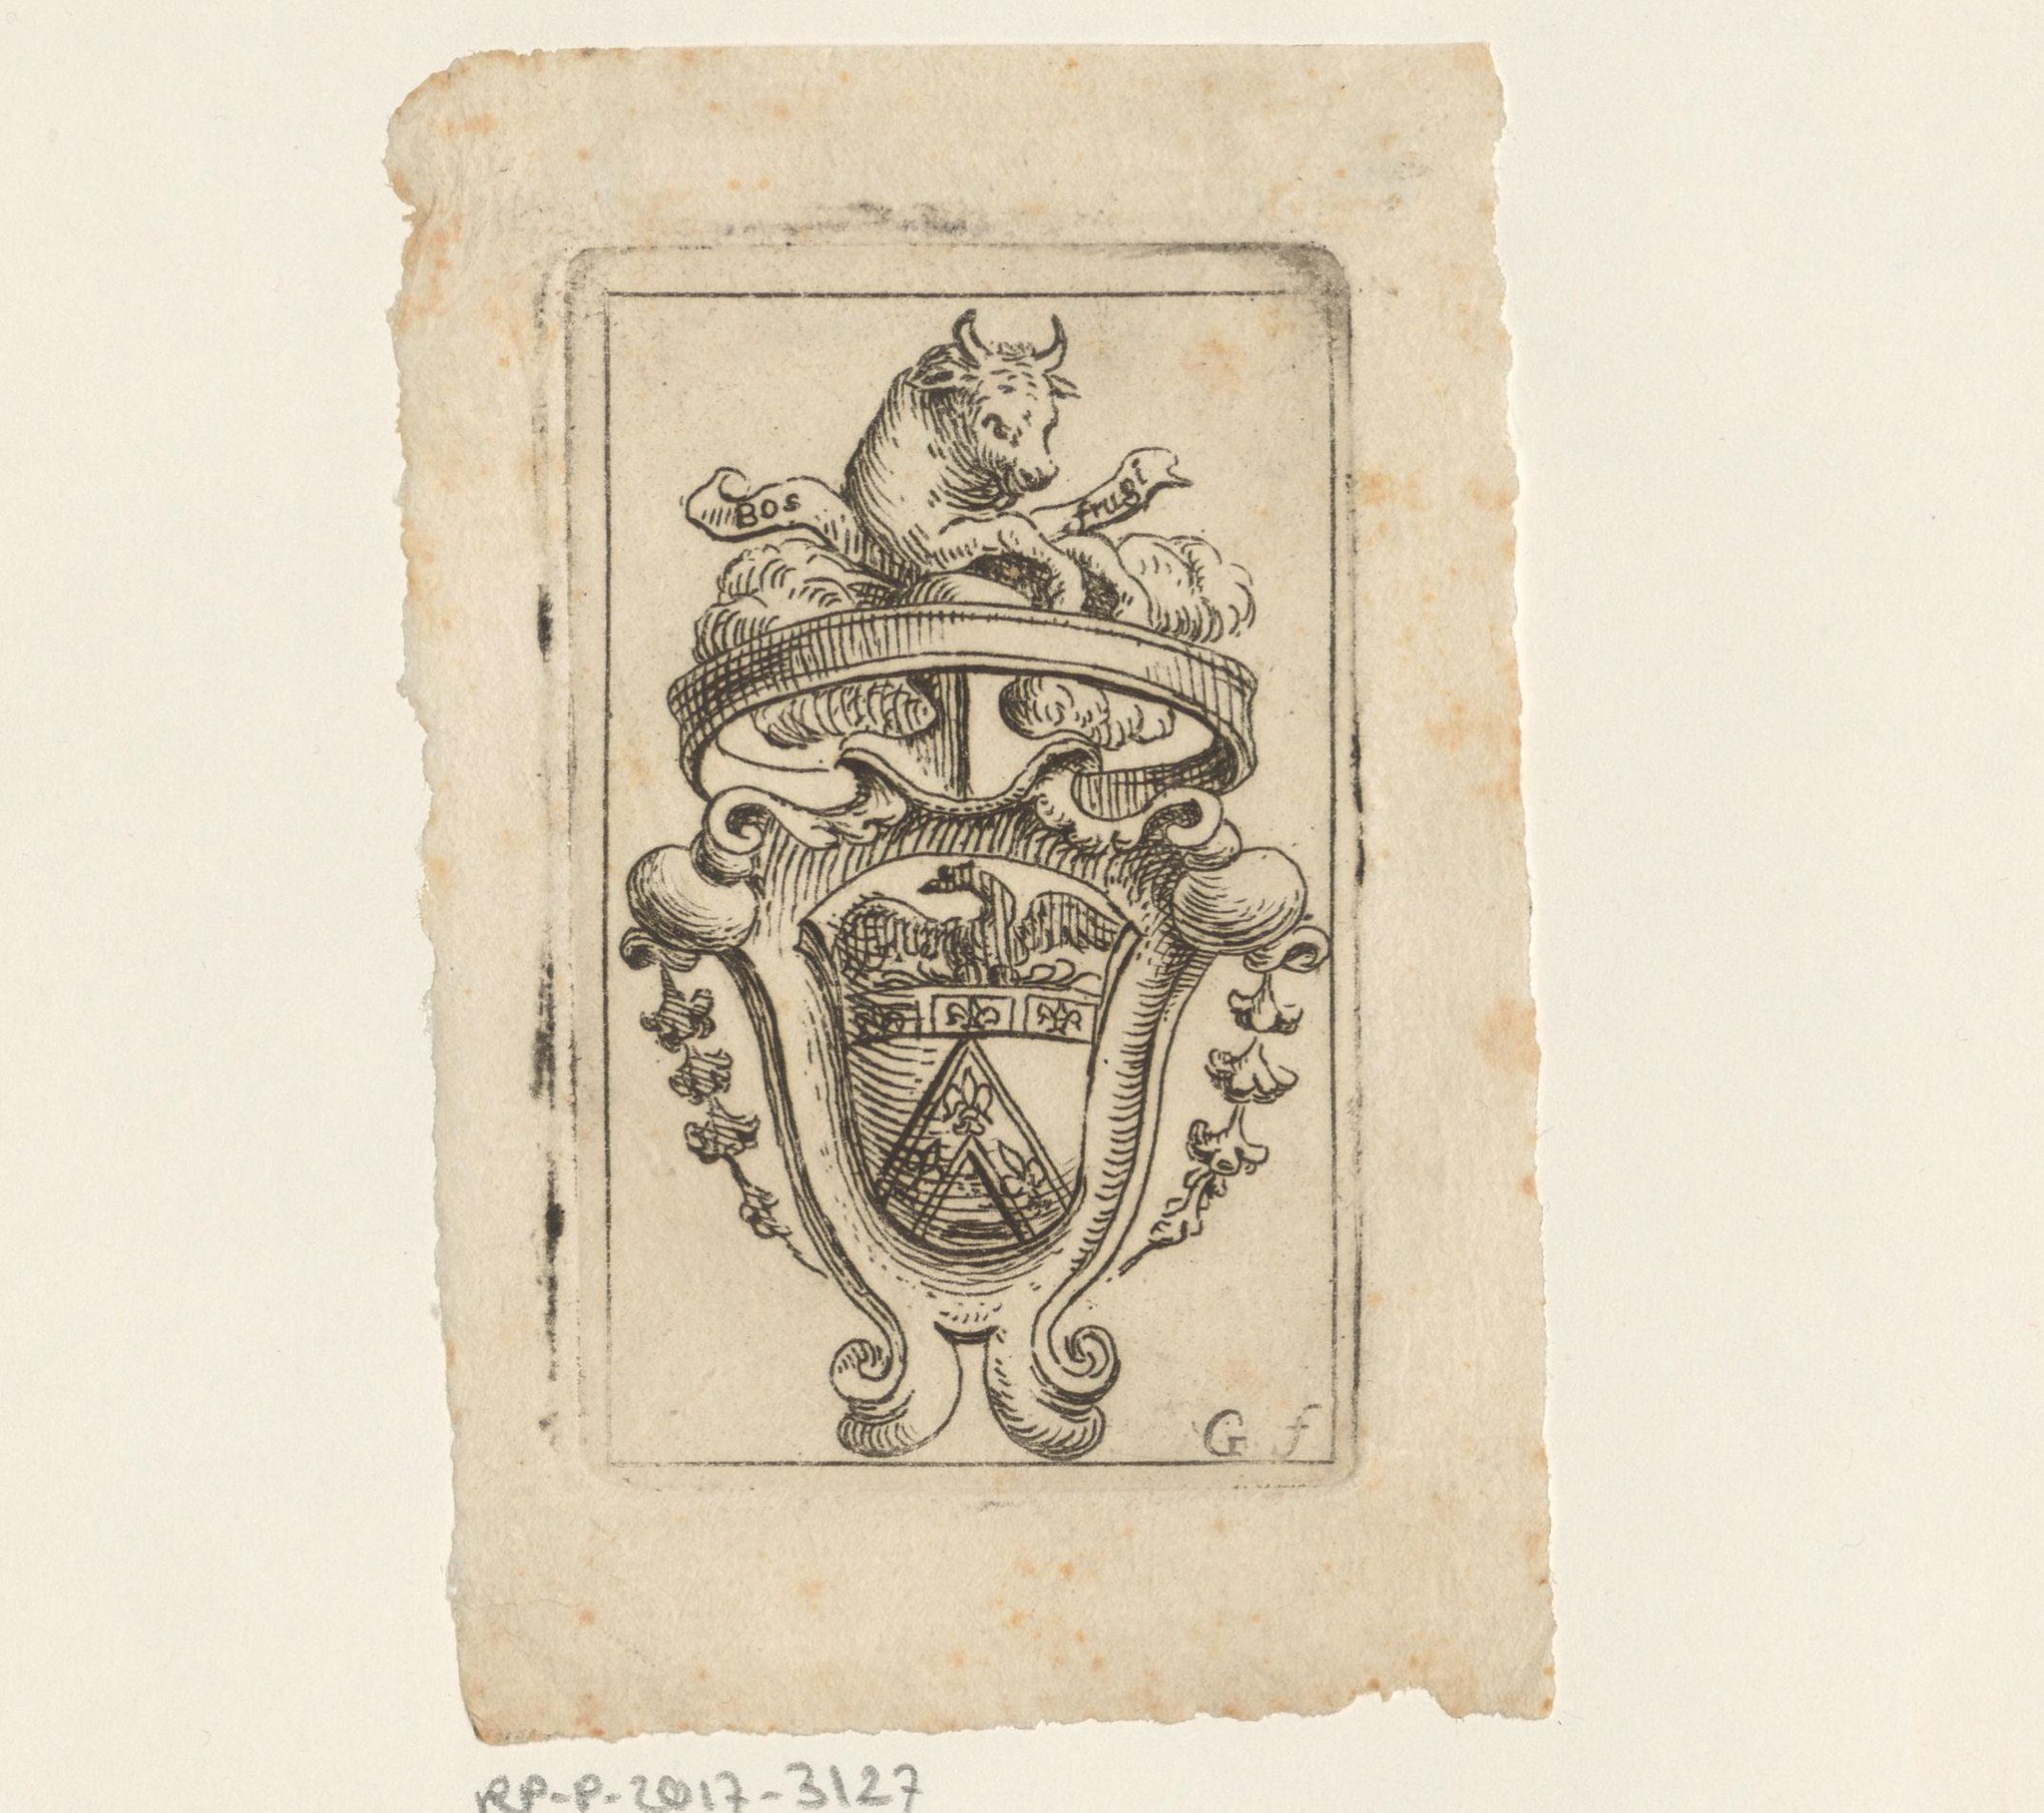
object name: bookplate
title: Ex libris van onbekend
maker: Anonymous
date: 1780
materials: paper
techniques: etching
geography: bologna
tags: bull, predatory birds: eagle, armorial bearing, heraldry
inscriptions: inscription: ‘fam. Bovio 1780 / Bologna’